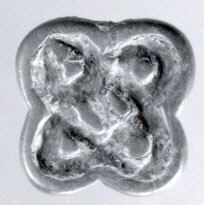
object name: stamp seal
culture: bactria-margiana archaeological complex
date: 2333-1668 BCE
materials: copper alloy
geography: bactria-margiana